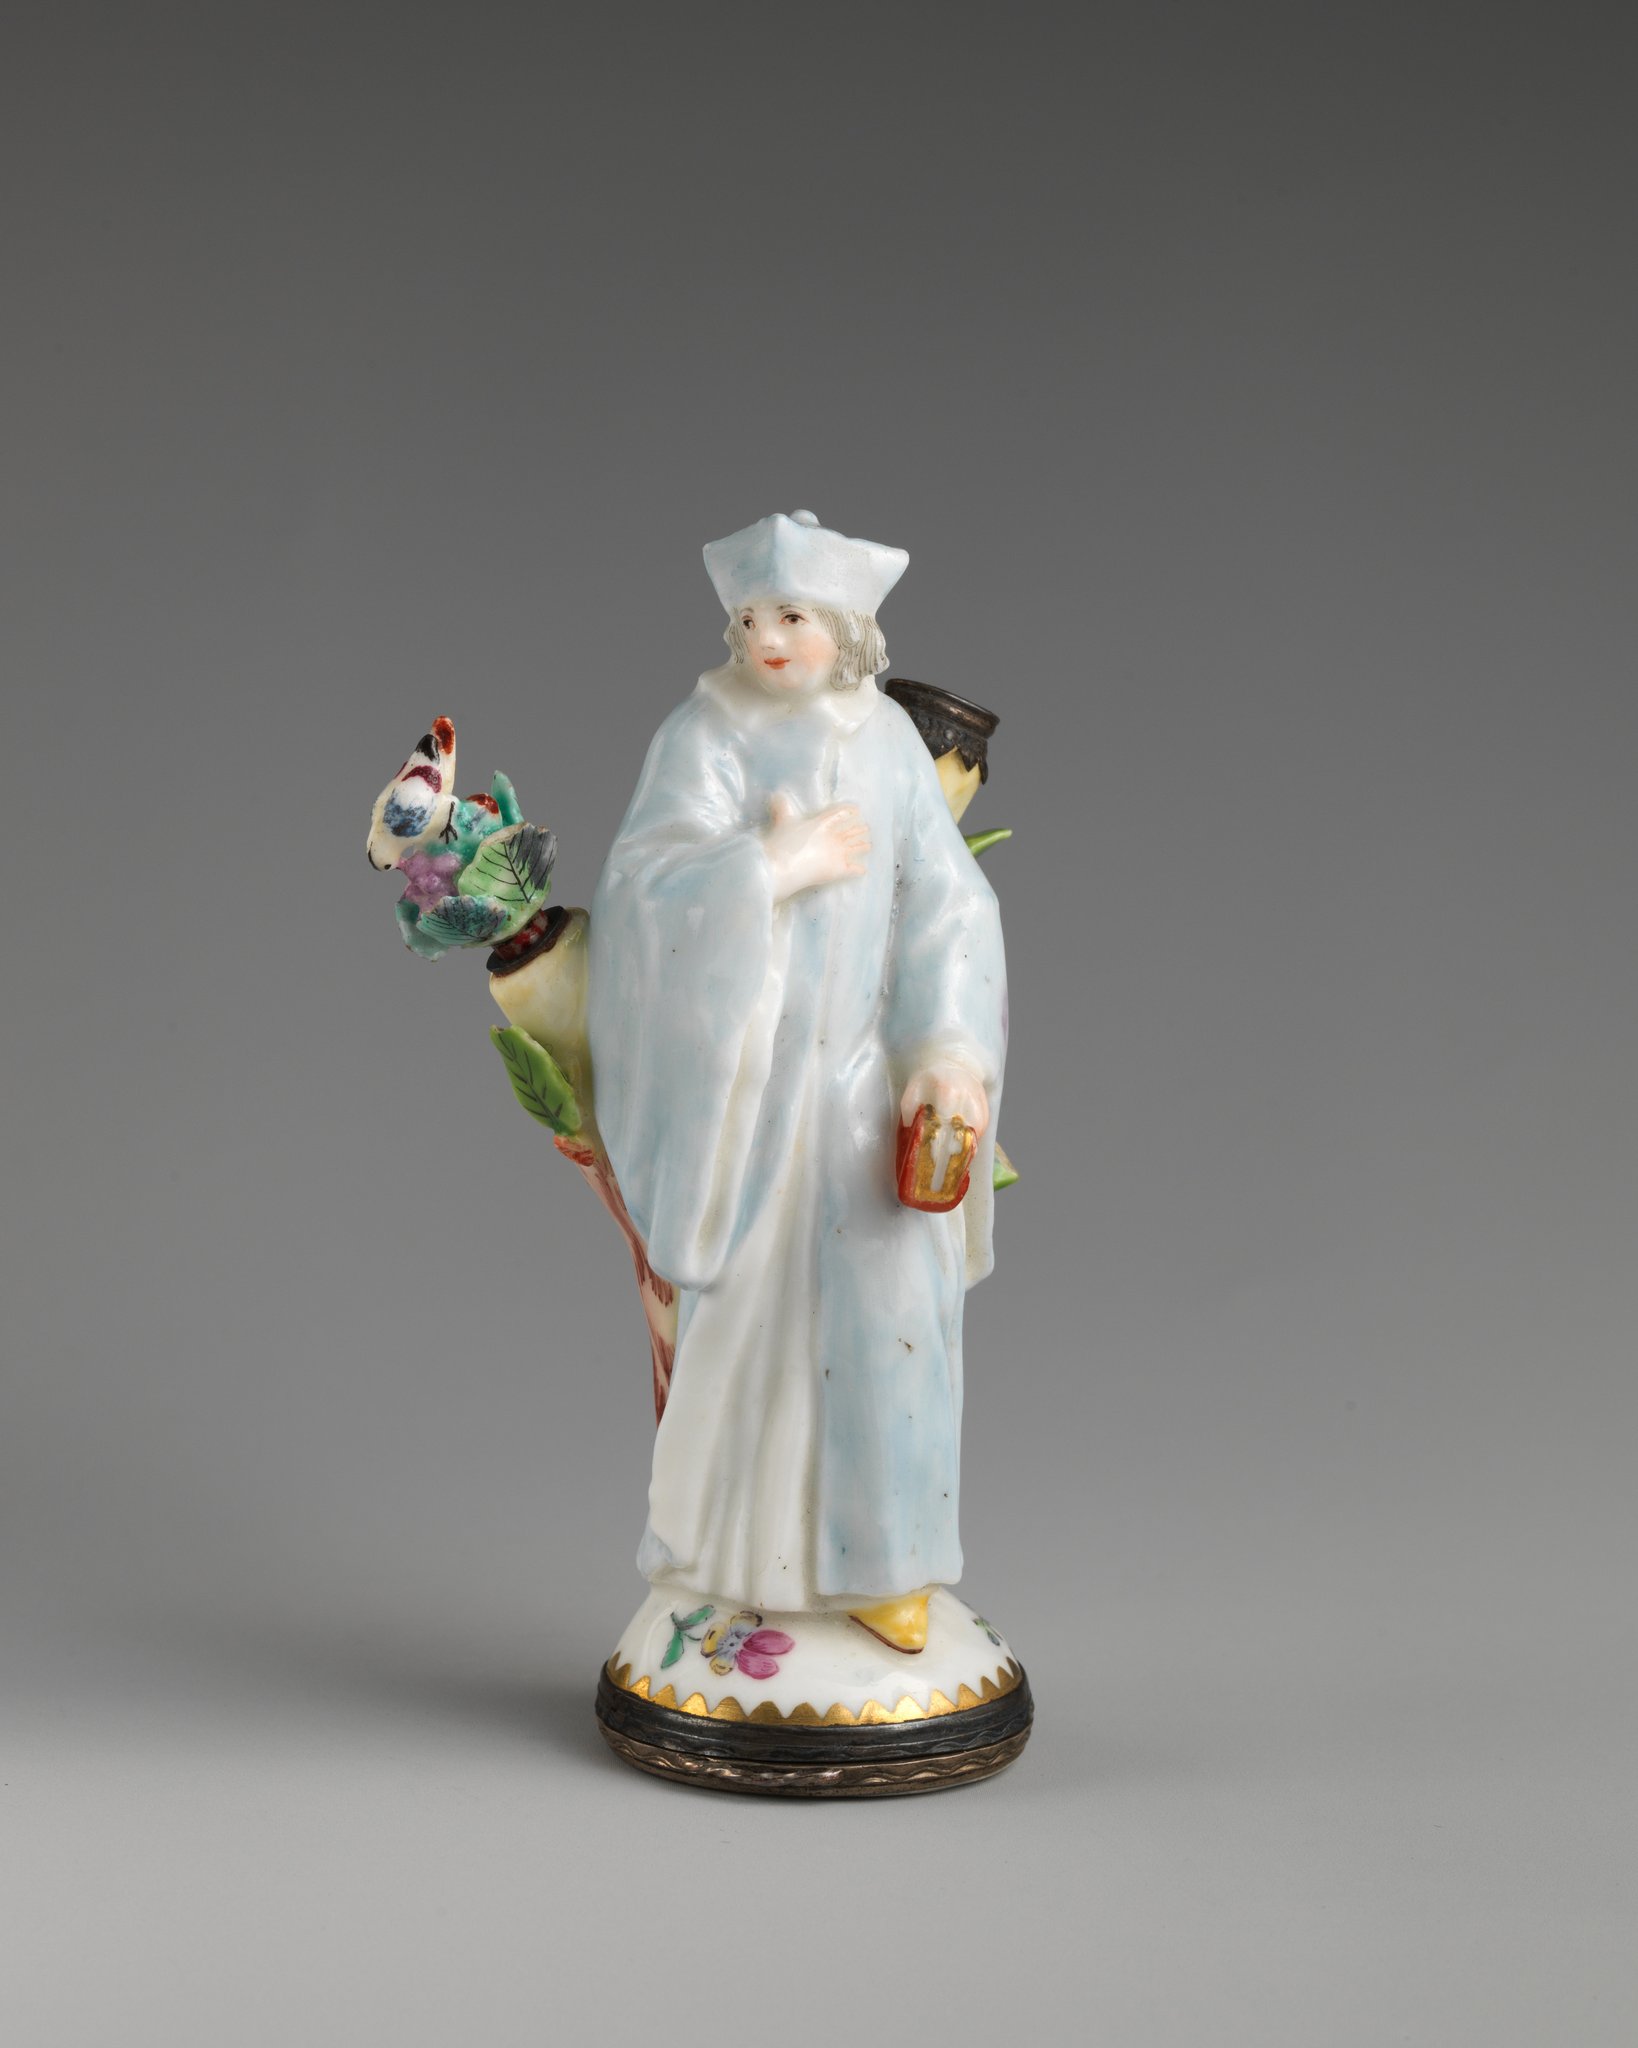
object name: scent bottle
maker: chelsea porcelain manufactory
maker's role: factory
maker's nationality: british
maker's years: 1744-1784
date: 1755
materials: soft paste porcelain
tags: birds,women,roses